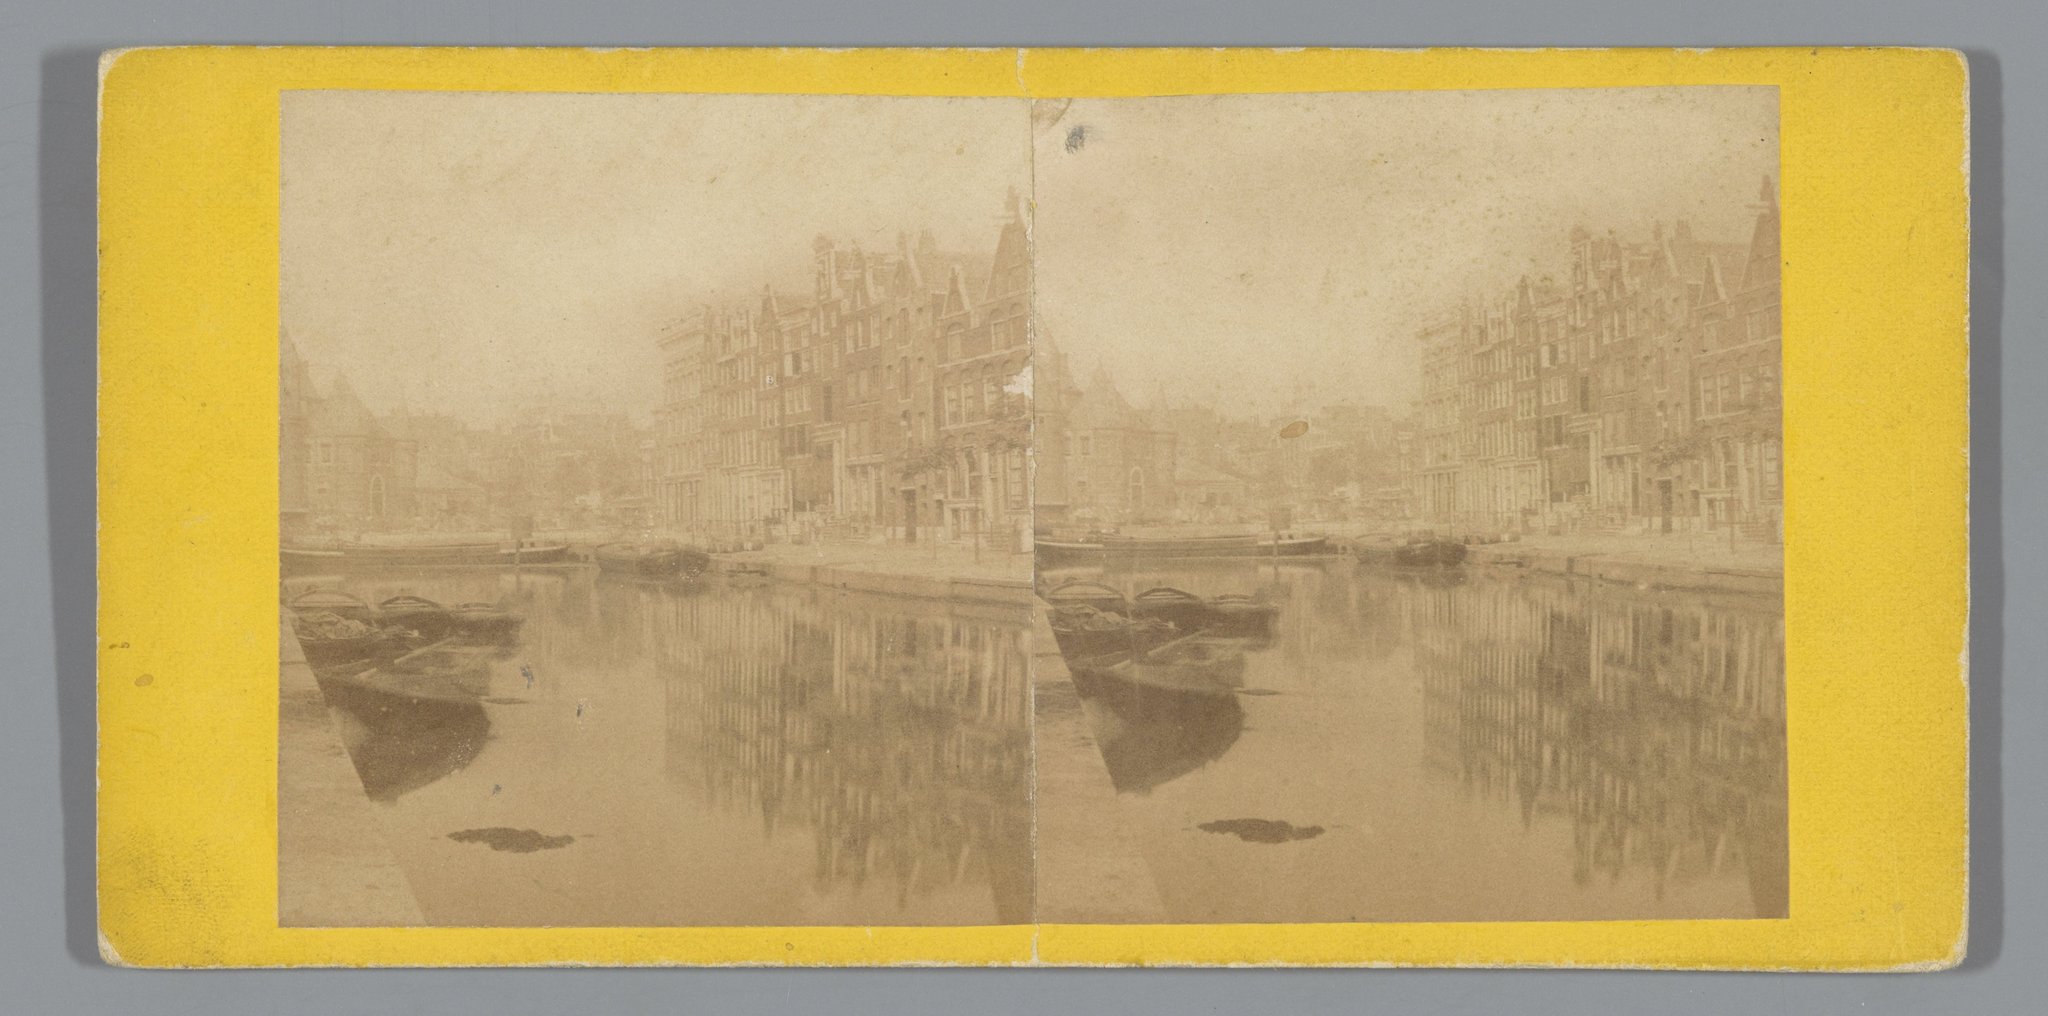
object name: stereograph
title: Kloveniersburgwal met Waag, Amsterdam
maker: Anonymous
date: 1861-1870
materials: cardboard, paper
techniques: albumen print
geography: amsterdam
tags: canals, waters (in city)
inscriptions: inscription: ‘Amsterdam/ Hollande/ Kloveniersburgwal met/ Waag’